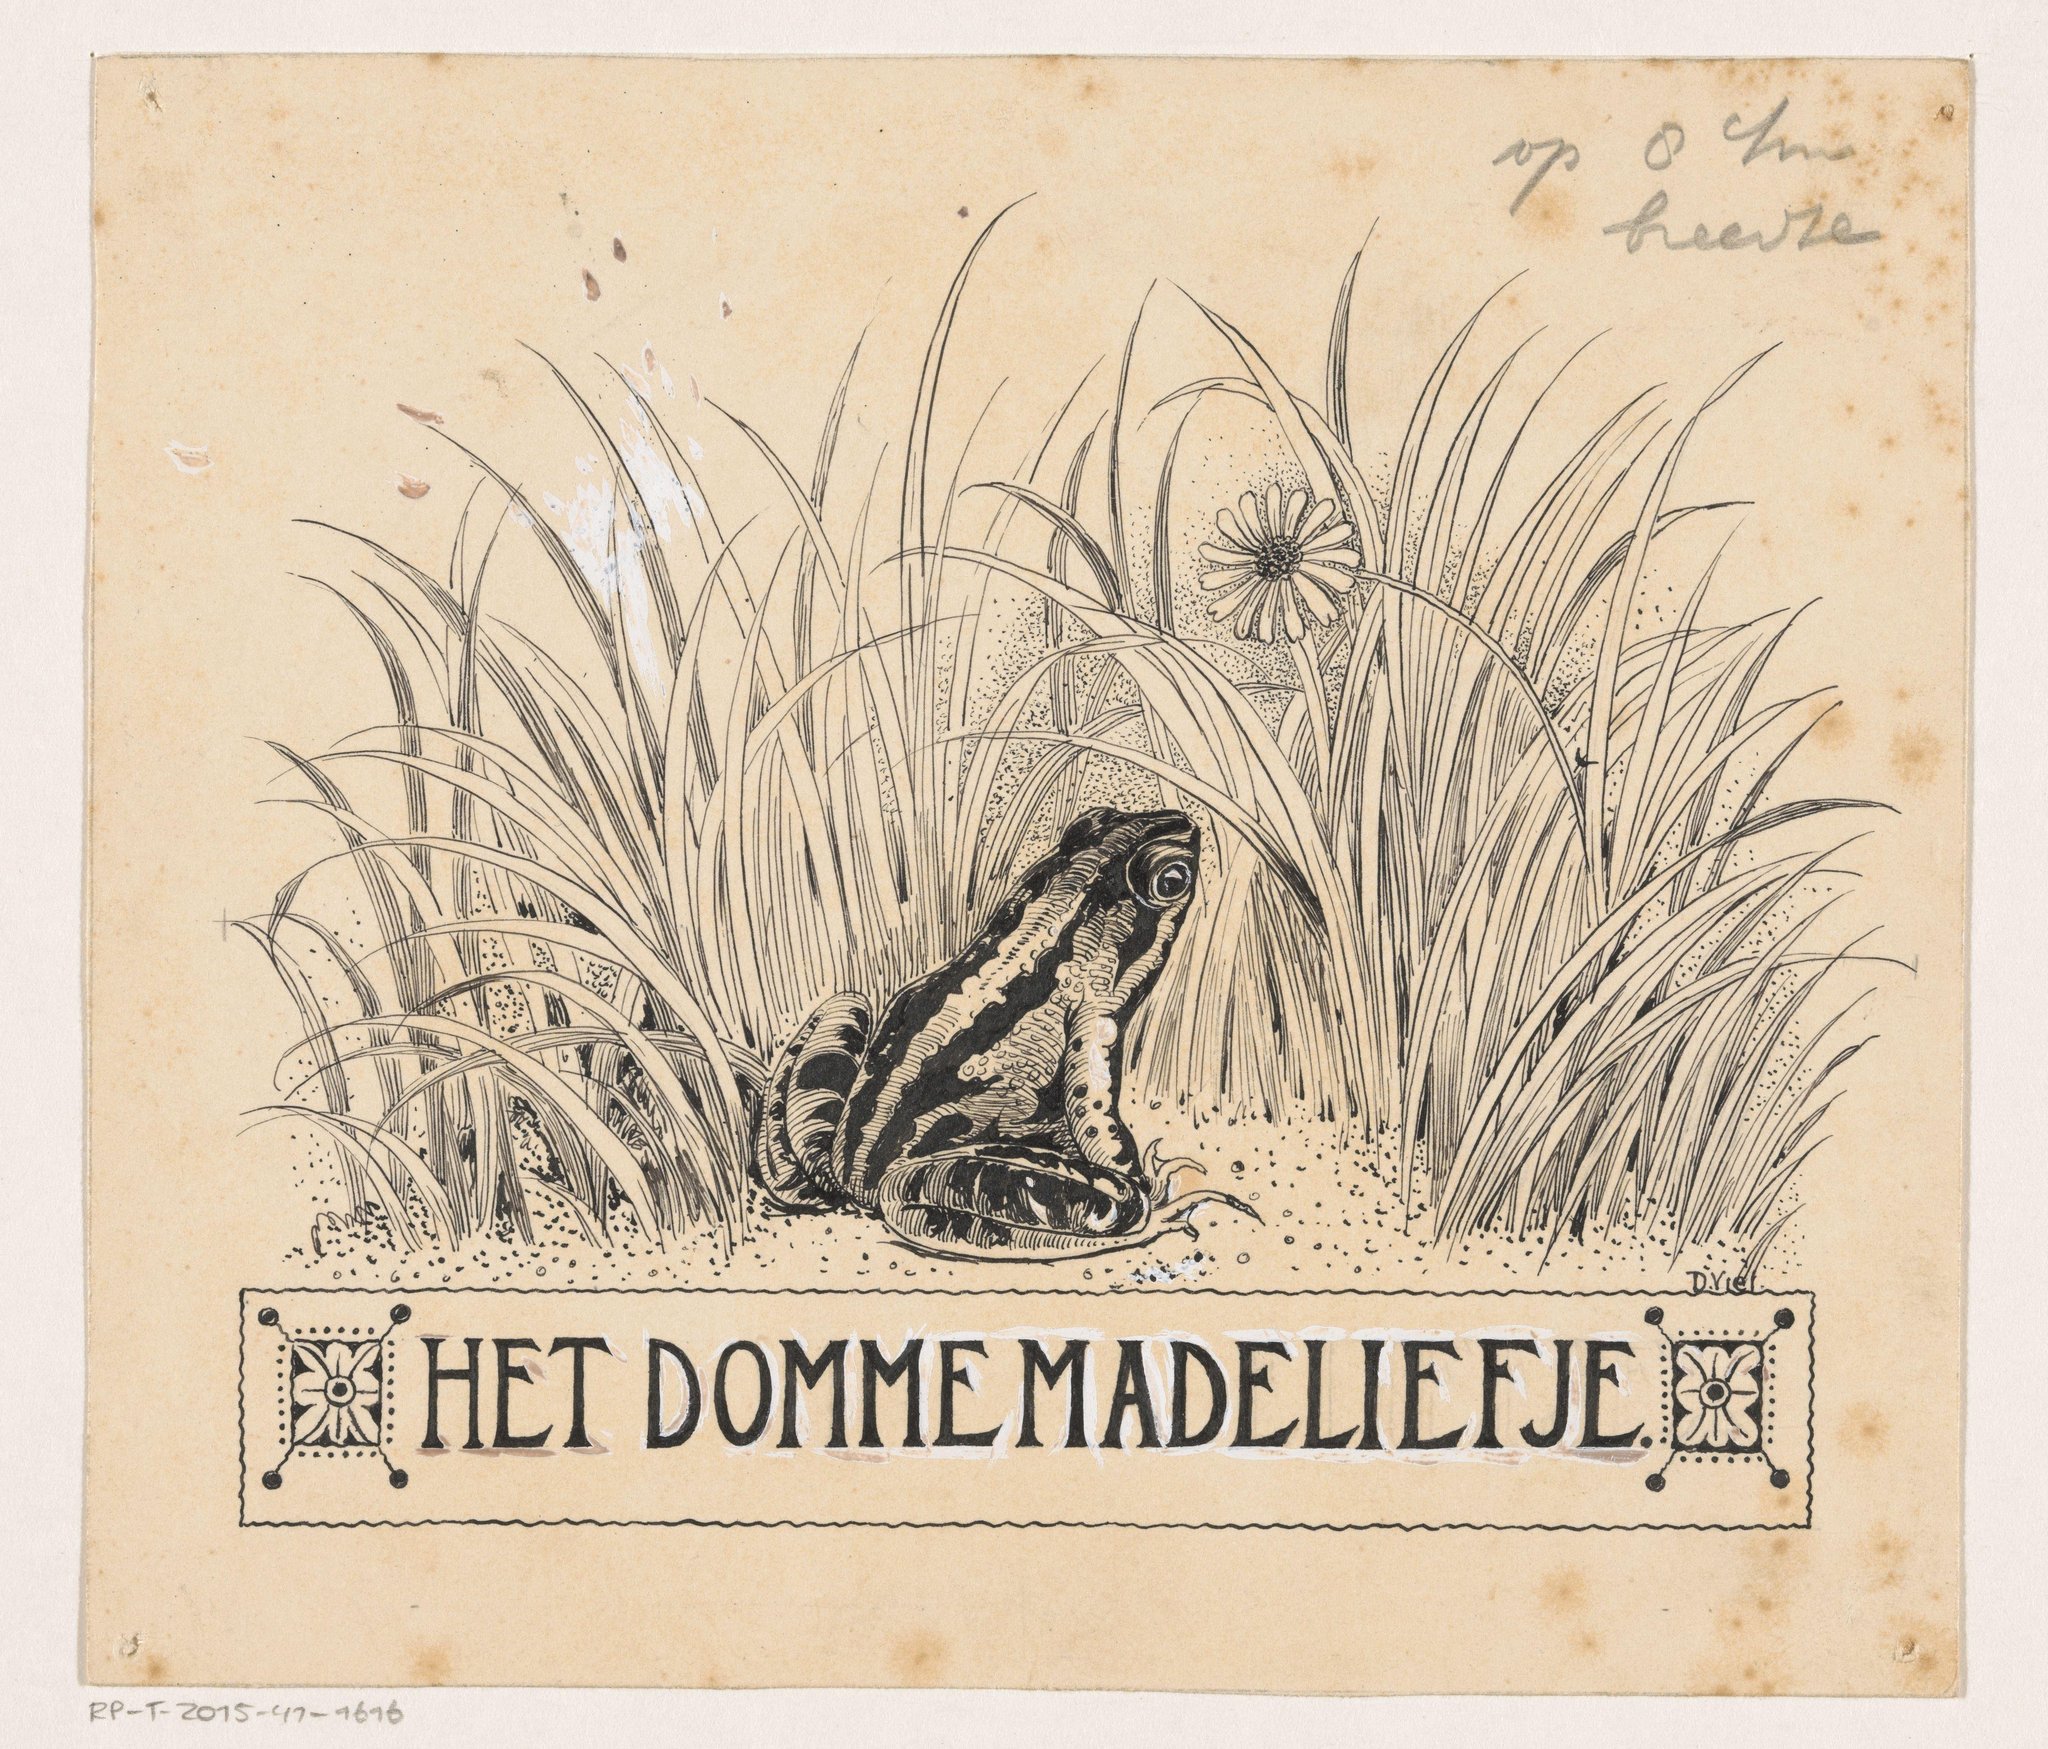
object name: drawing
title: Het domme madeliefje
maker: d. viel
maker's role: draughtsman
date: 1915-1935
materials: paint, ink, paper, pencil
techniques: brush, pen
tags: tailless amphibians: frog, flowers: daisy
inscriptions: :, signature: ‘D. Viel.’, collector's mark: Lugt 2228